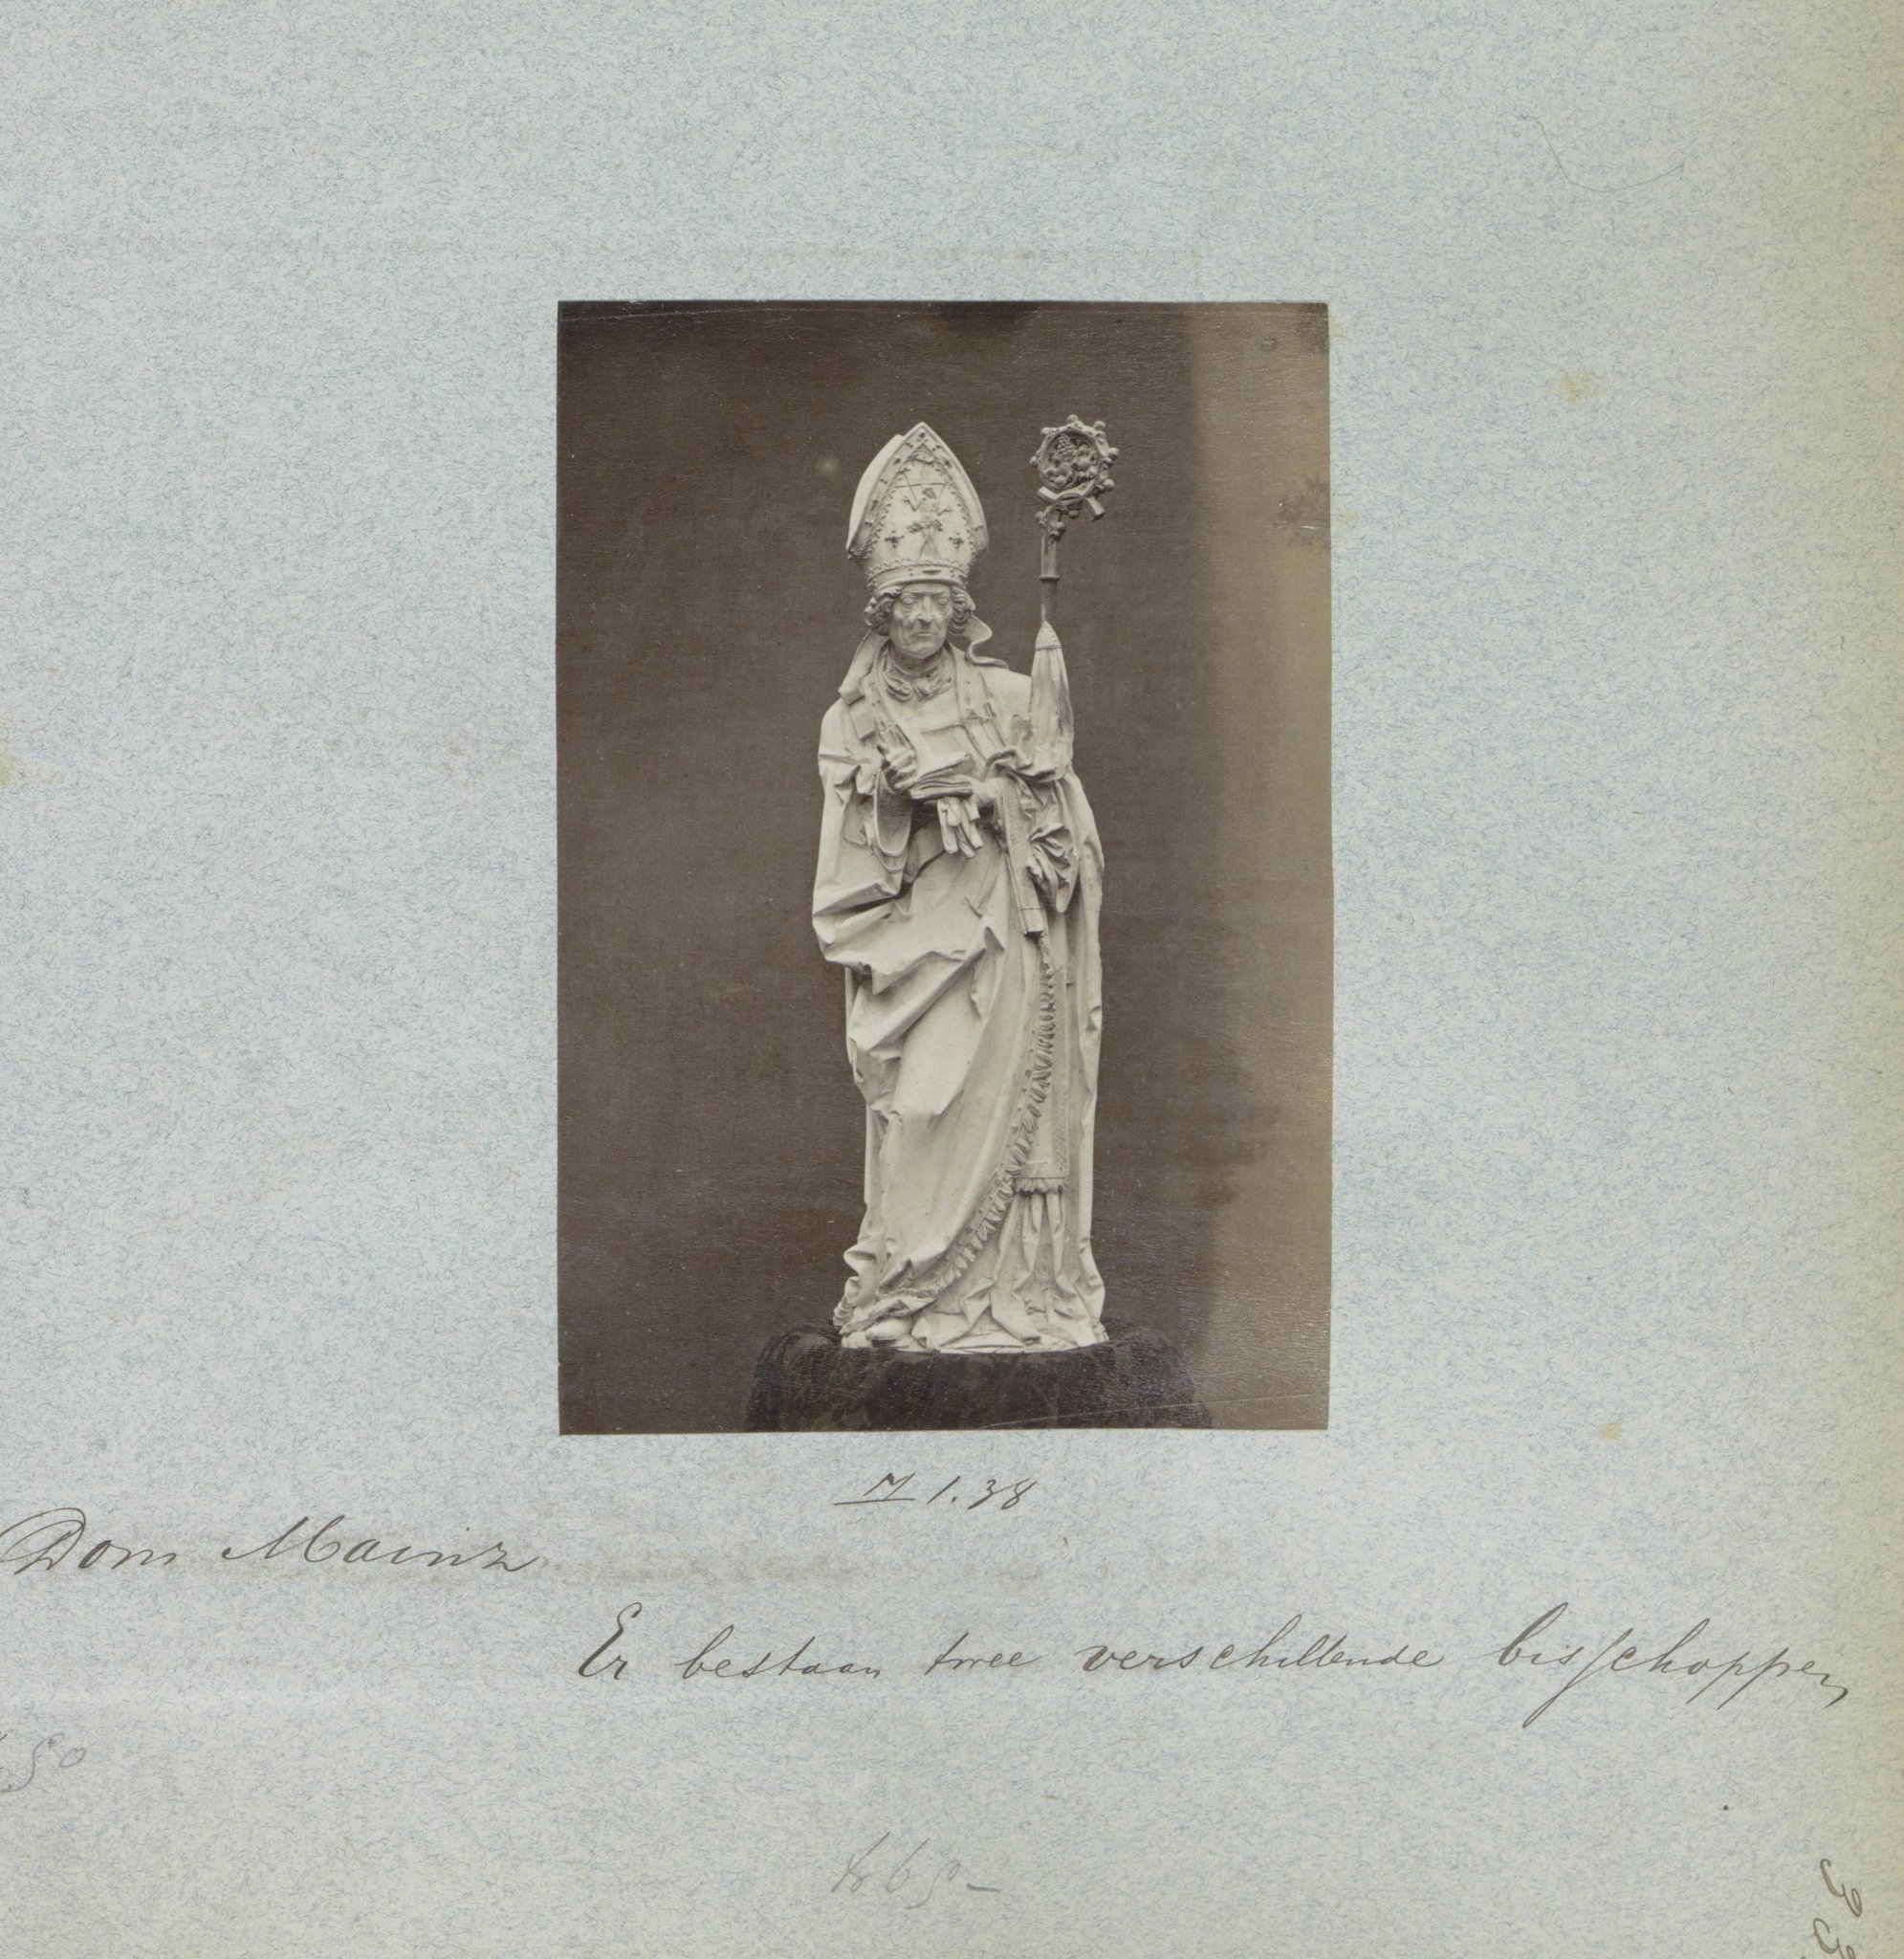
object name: album leaf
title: Sculptuur van Maria met kind uit de Dom van Mainz, te Duitsland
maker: Anonymous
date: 1875-1900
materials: paper, photographic support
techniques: albumen print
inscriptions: annotation: ‘M 1.36’, annotation: ‘Dom Mainz’, annotation